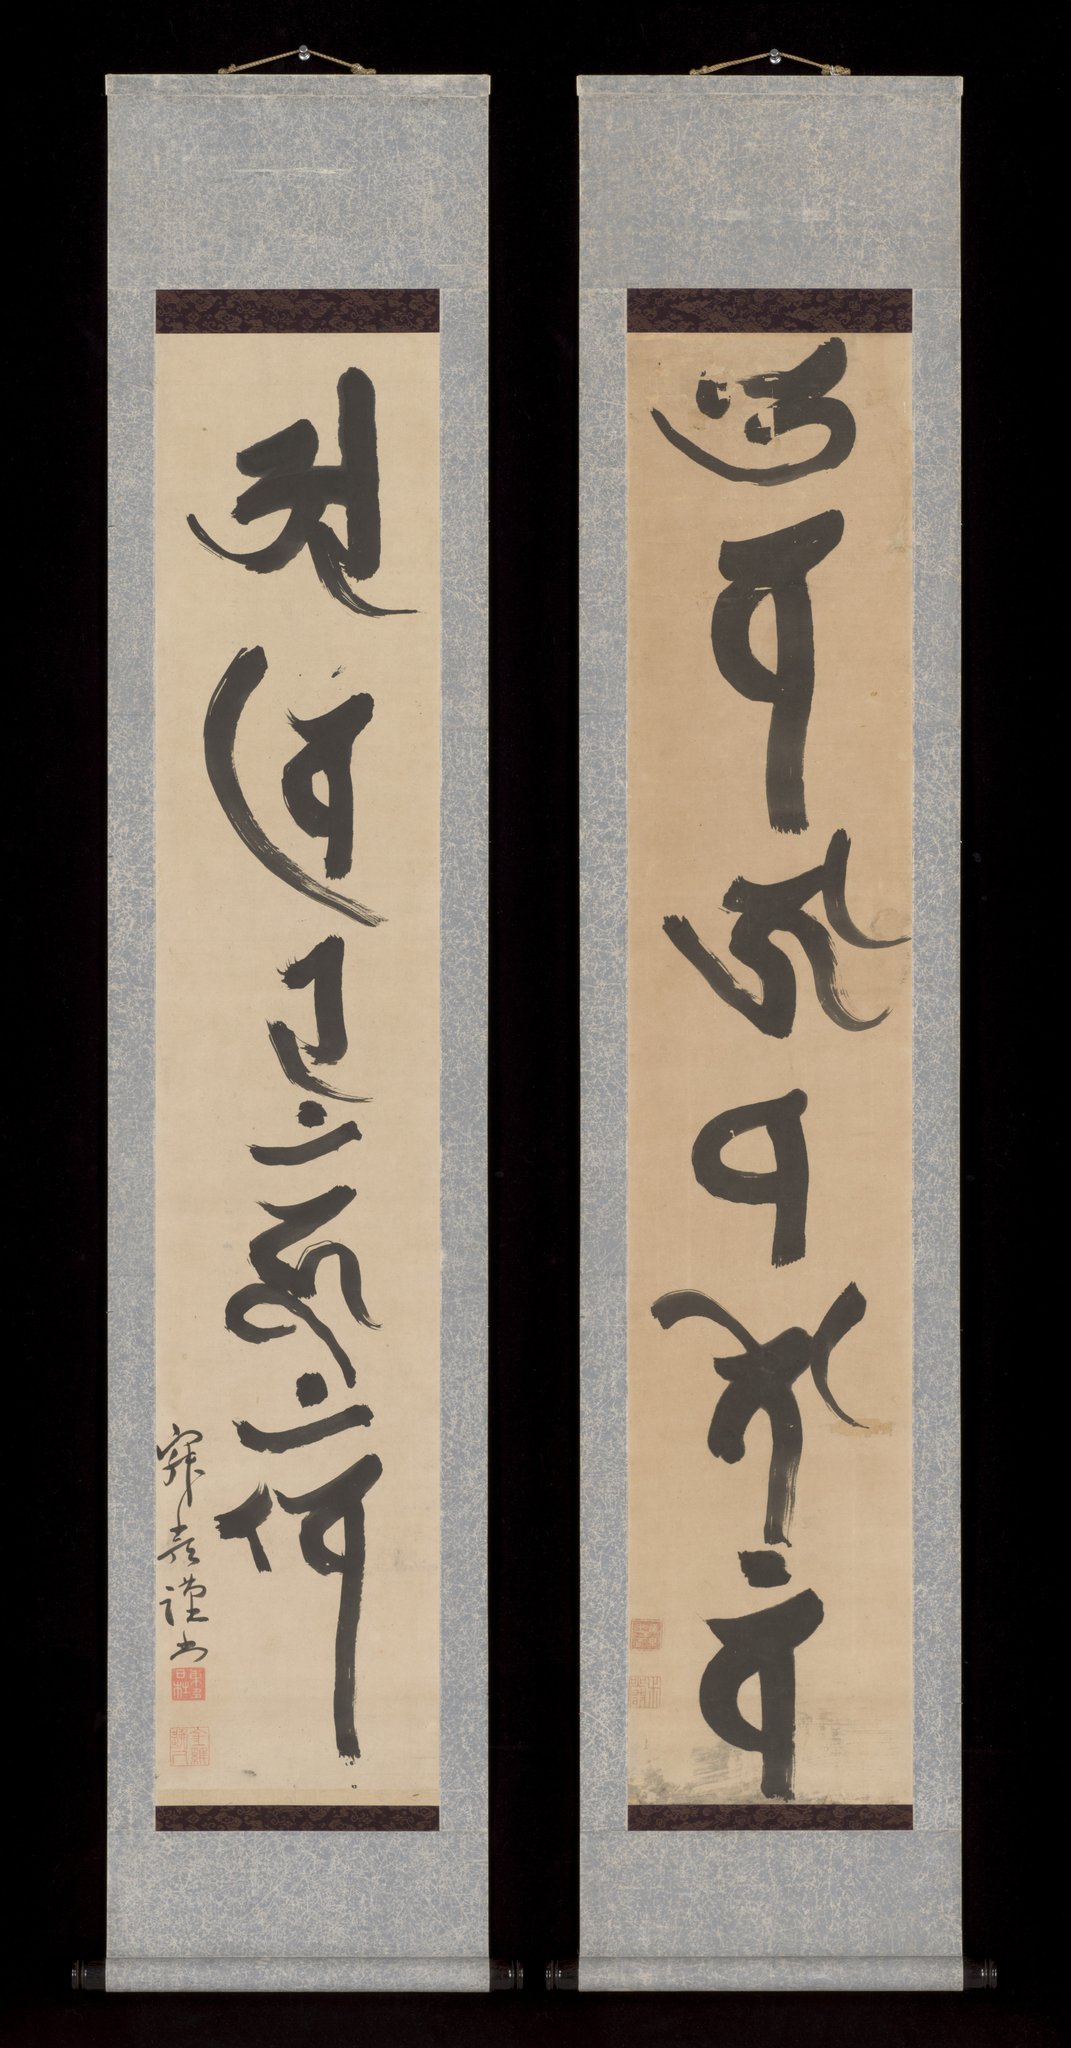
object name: hanging scroll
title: Mantras of the Two Realms in Sanskrit Script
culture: japanese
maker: jakugon taijō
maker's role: artist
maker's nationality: japanese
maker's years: 1702-1771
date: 1767-1771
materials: ink, paper